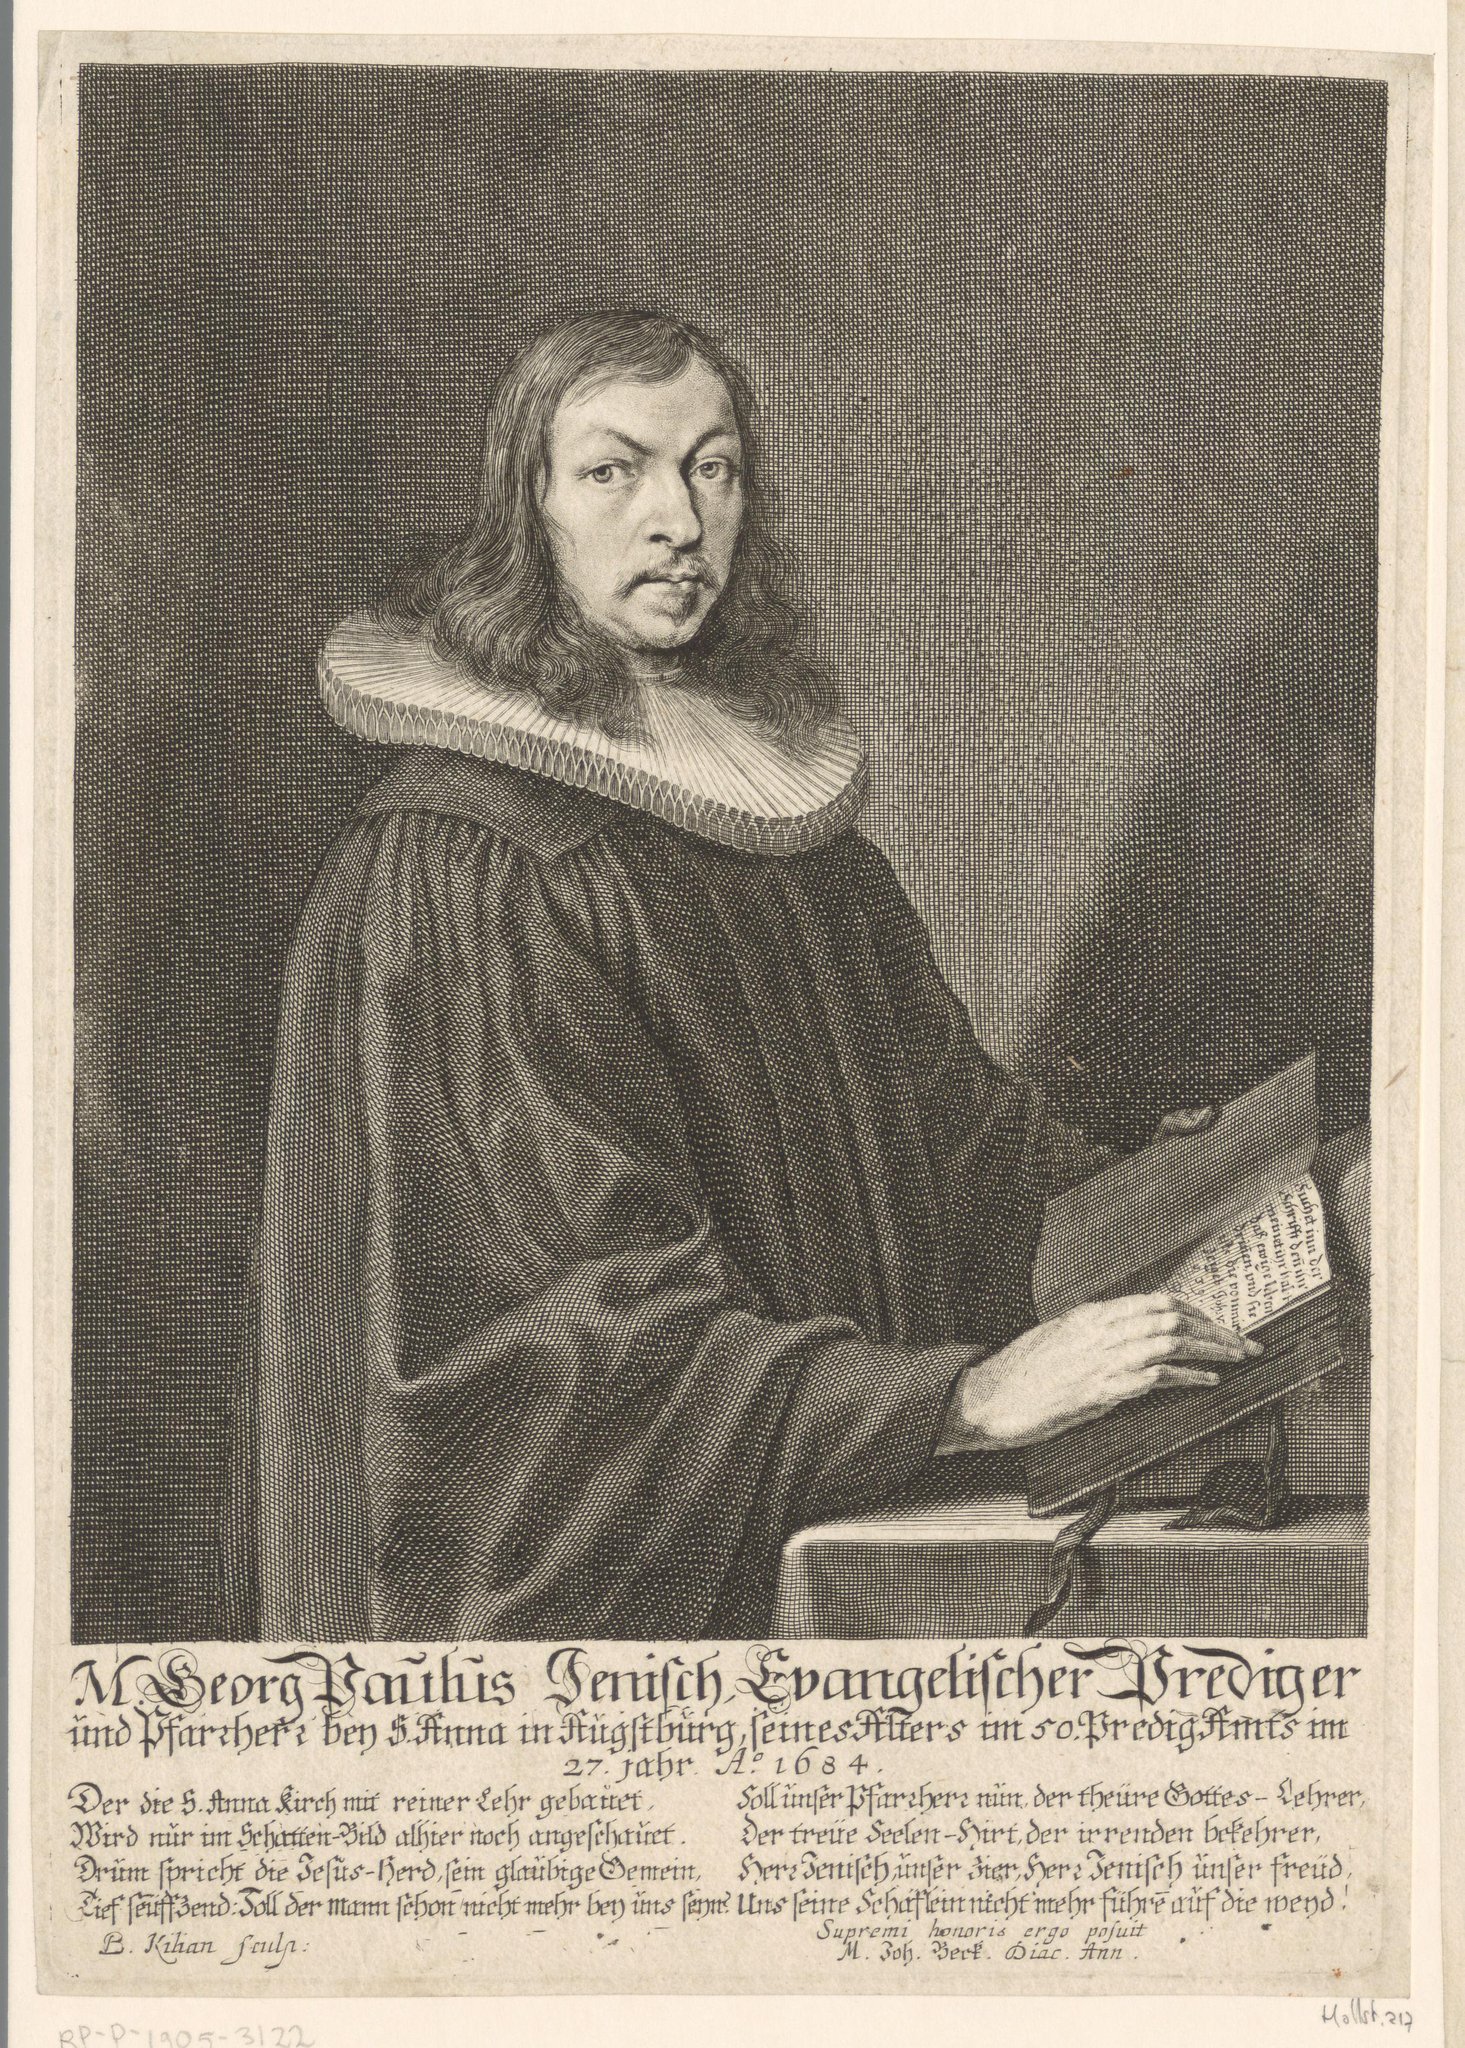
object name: print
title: Portret van Georg Paul Jenisch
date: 1684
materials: paper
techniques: engraving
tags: augsburg, georg paul jenisch, theologian, historical persons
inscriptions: collector's mark: Lugt 2228